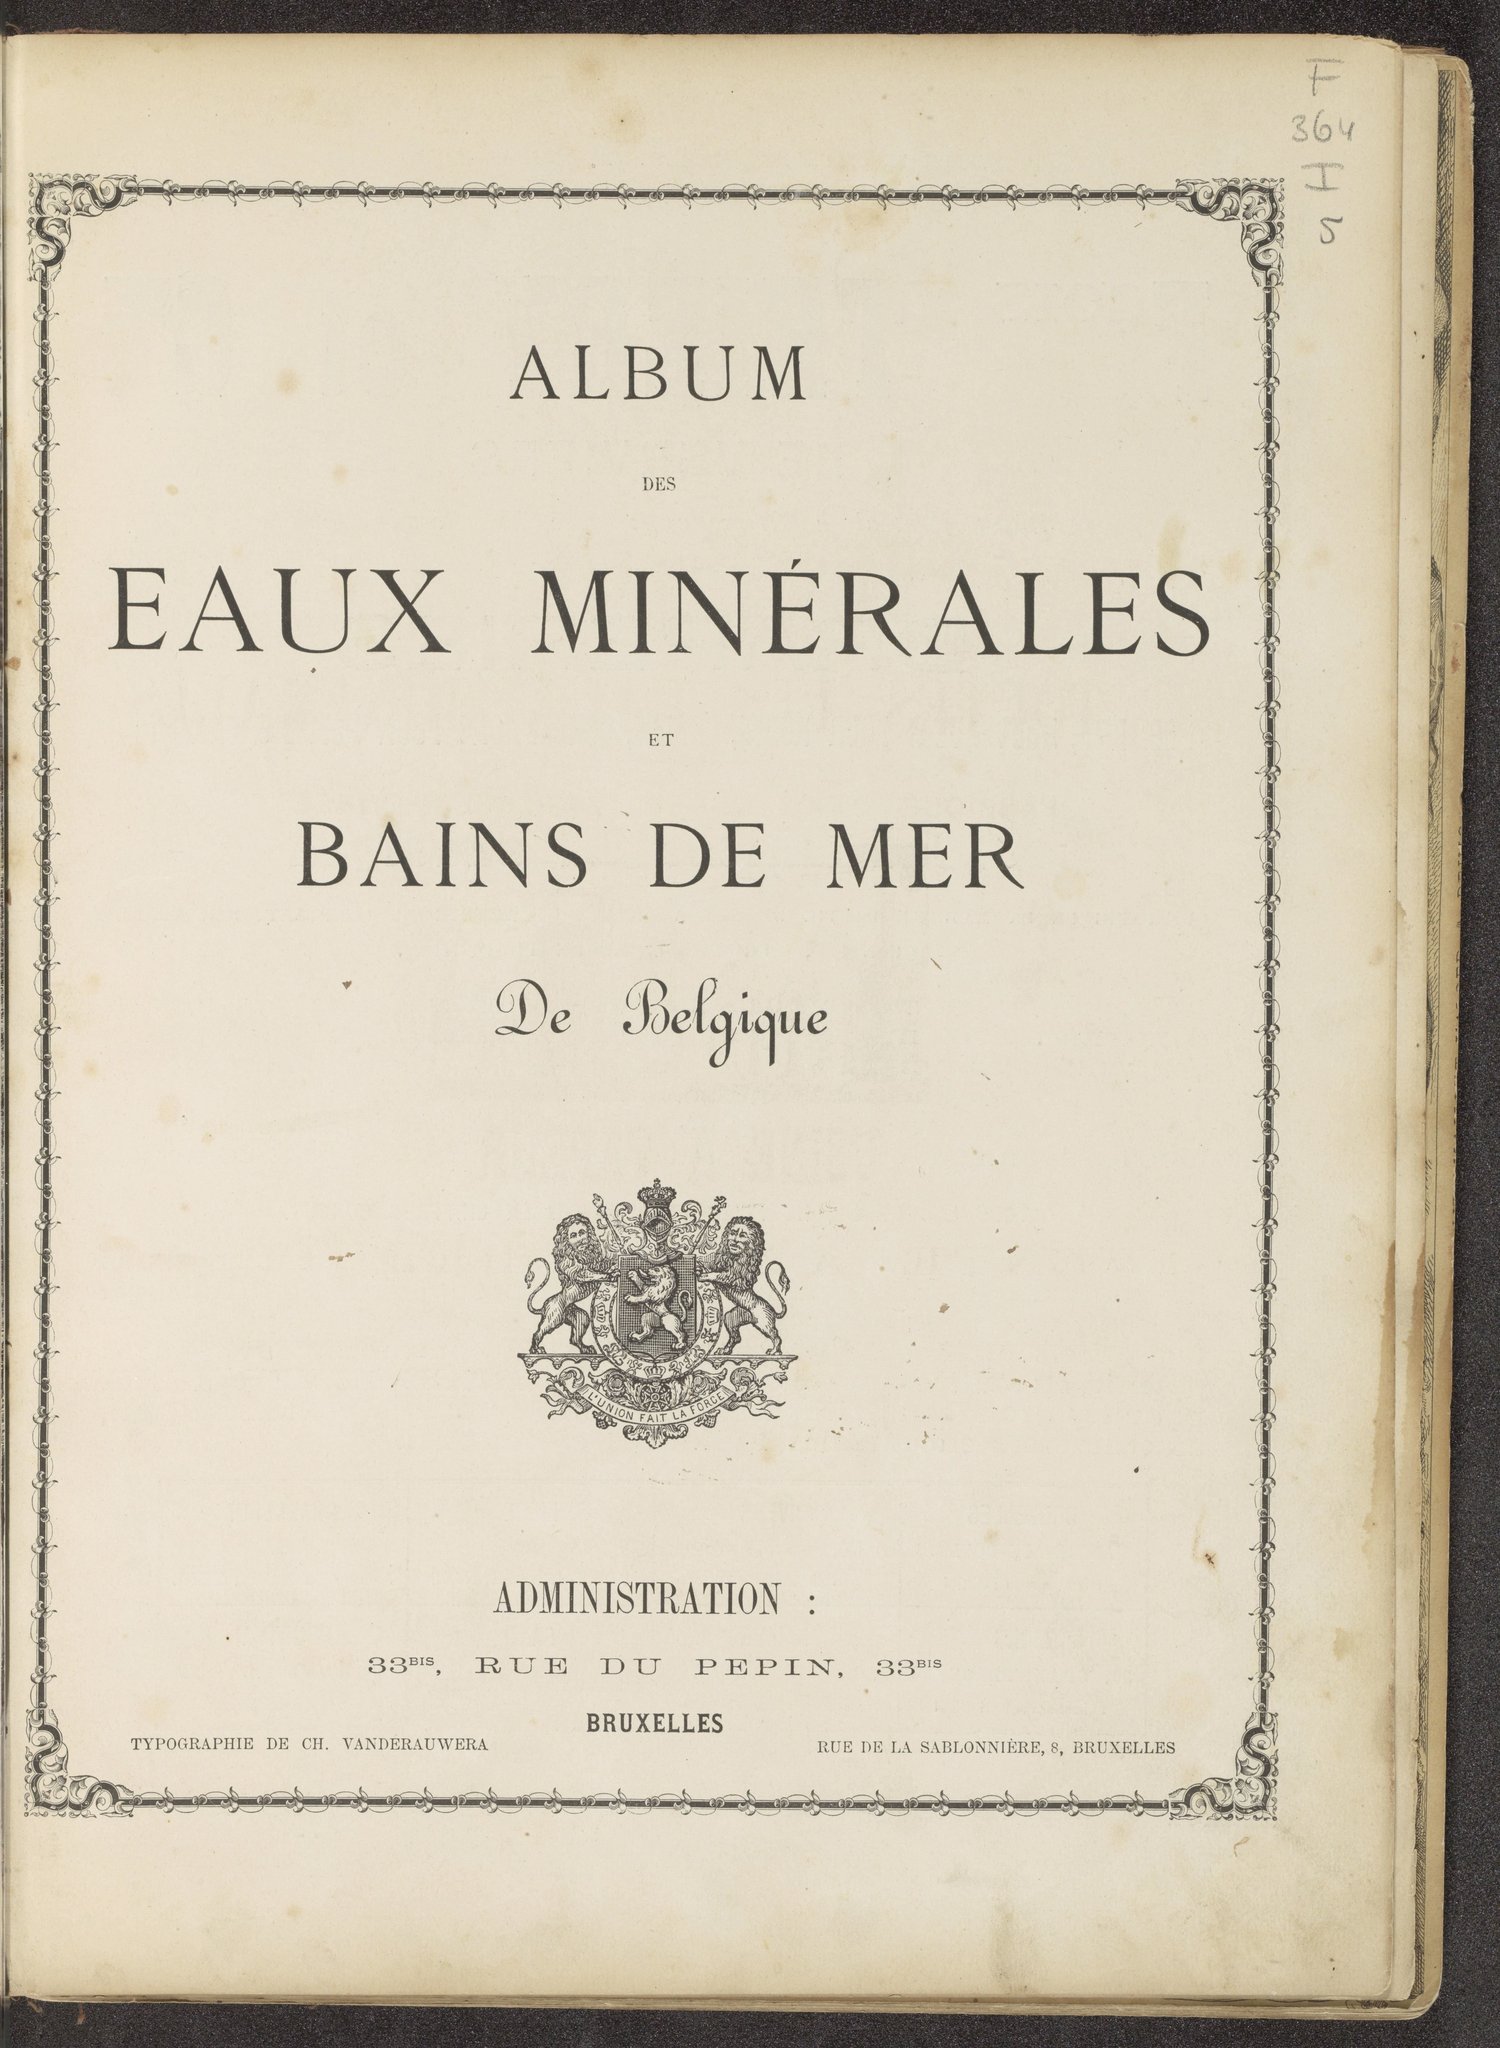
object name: book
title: Advertisement Photographs of Socks and Shoes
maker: ch. vanderauwera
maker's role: printer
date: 1872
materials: cardboard, linen, paper, photographic support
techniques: albumen print, engraving, printing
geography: brussels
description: This is a rare early example of advertising photography, a genre that only fully came into its own in the 20th century. The book is a curious mishmash of entirely unrelated small advertising photographs and large topographical pictures. Most of the advertisers were established in Brussels, however the title refers to spas and sea bathing in Belgium. The book will thus have been intended for tourists.